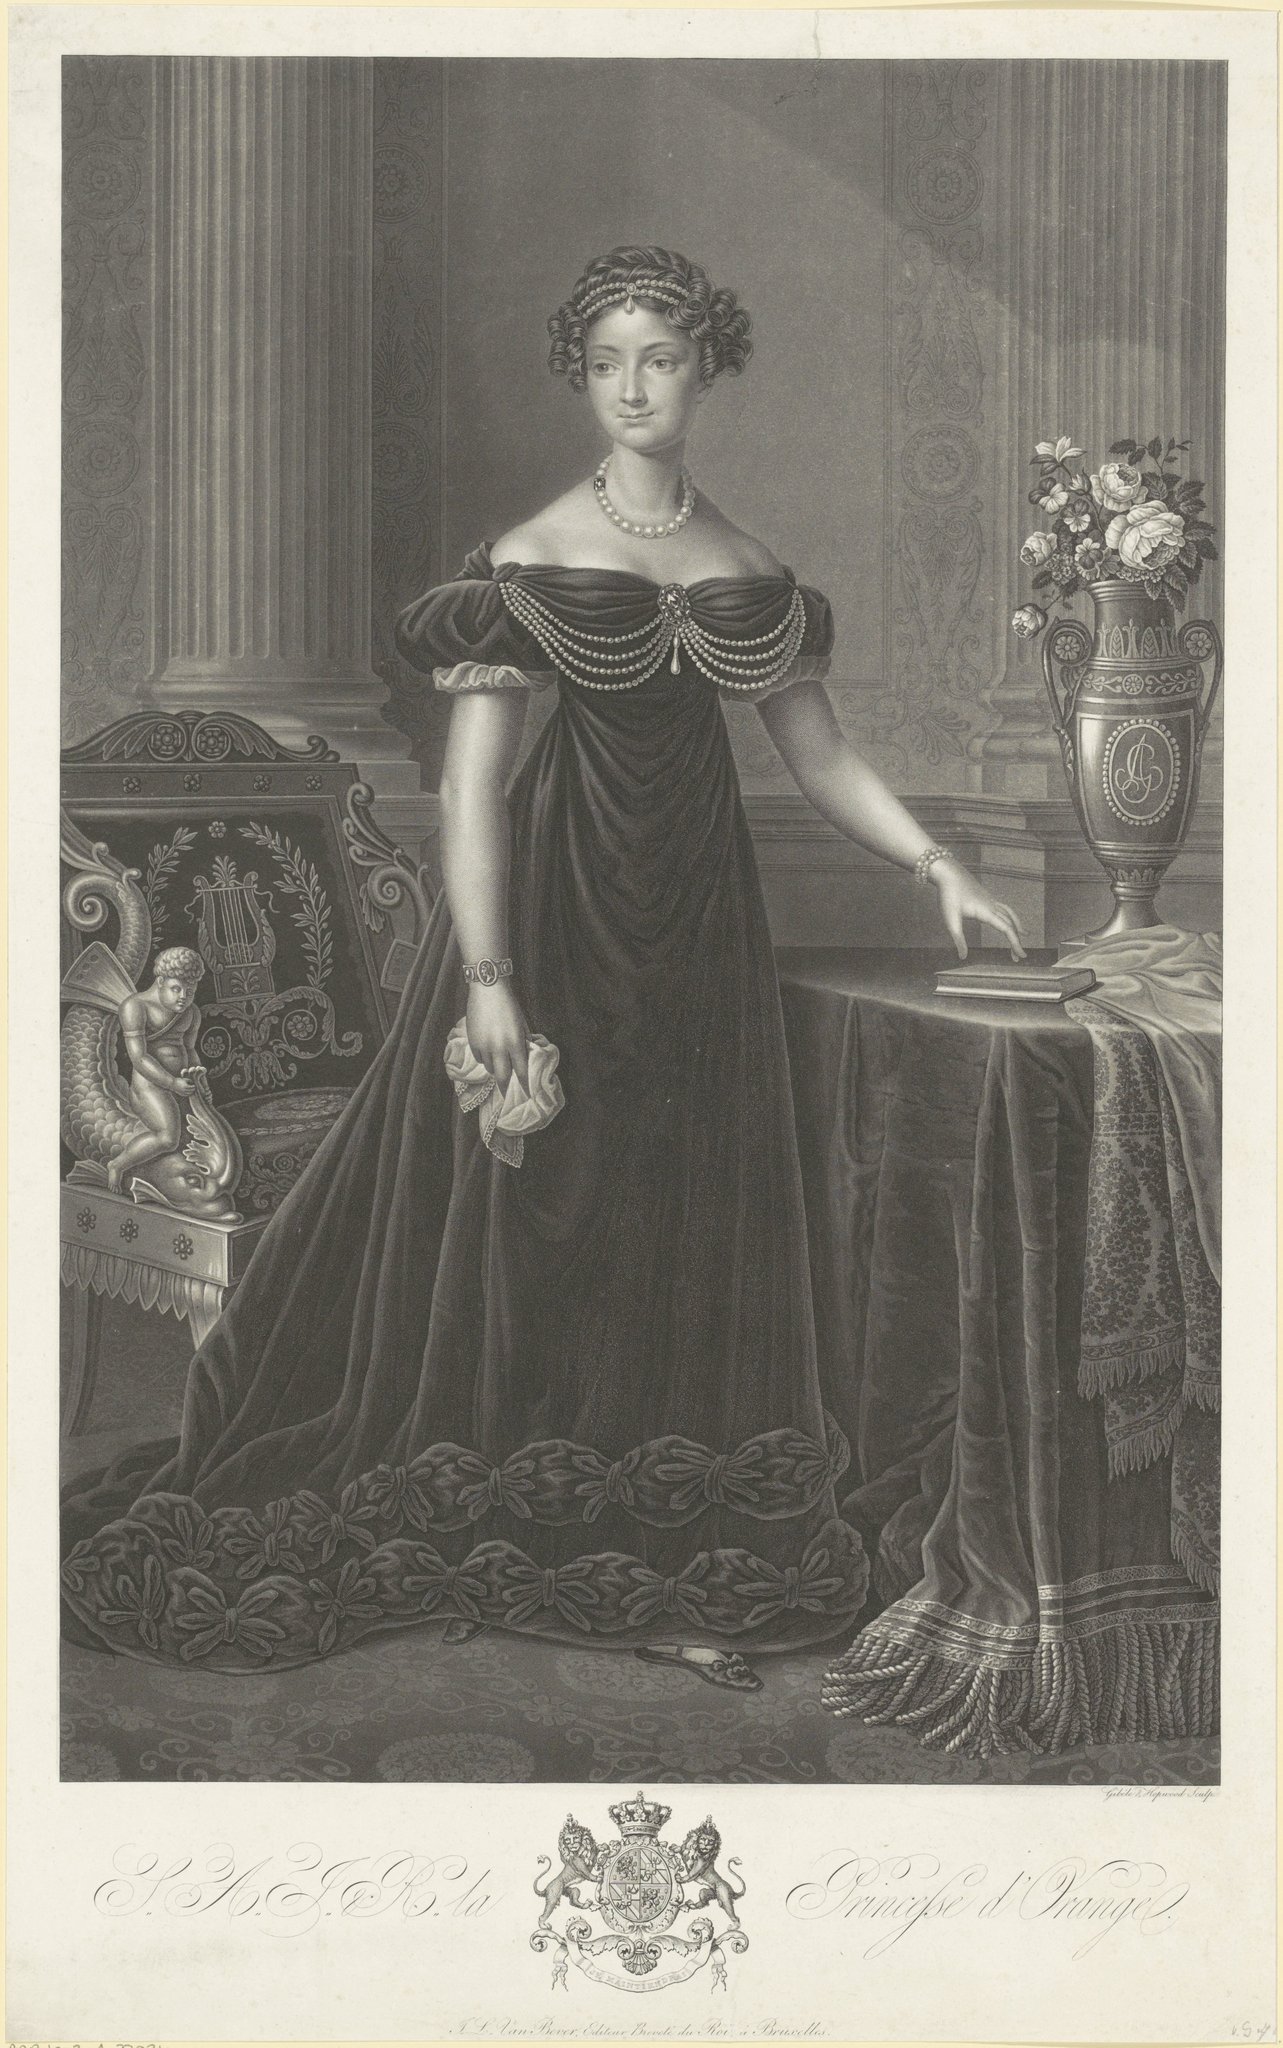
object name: print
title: Portret van Anna Paulowna Romanowa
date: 1816-1830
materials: paper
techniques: aquatint, etching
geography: brussels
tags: the hague, anna paulowna romanowa, william ii of the netherlands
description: Portret van Anna Paulowna. In haar rechterhand een zakdoek. Ze staat naast een stoel en een tafel met daarop een boek. In de ondermarge het wapen van Willem II met een kroon en twee leeuwen. Daaronder op een banderol zijn geslachtsspreuk. In de ondermarge haar titel.